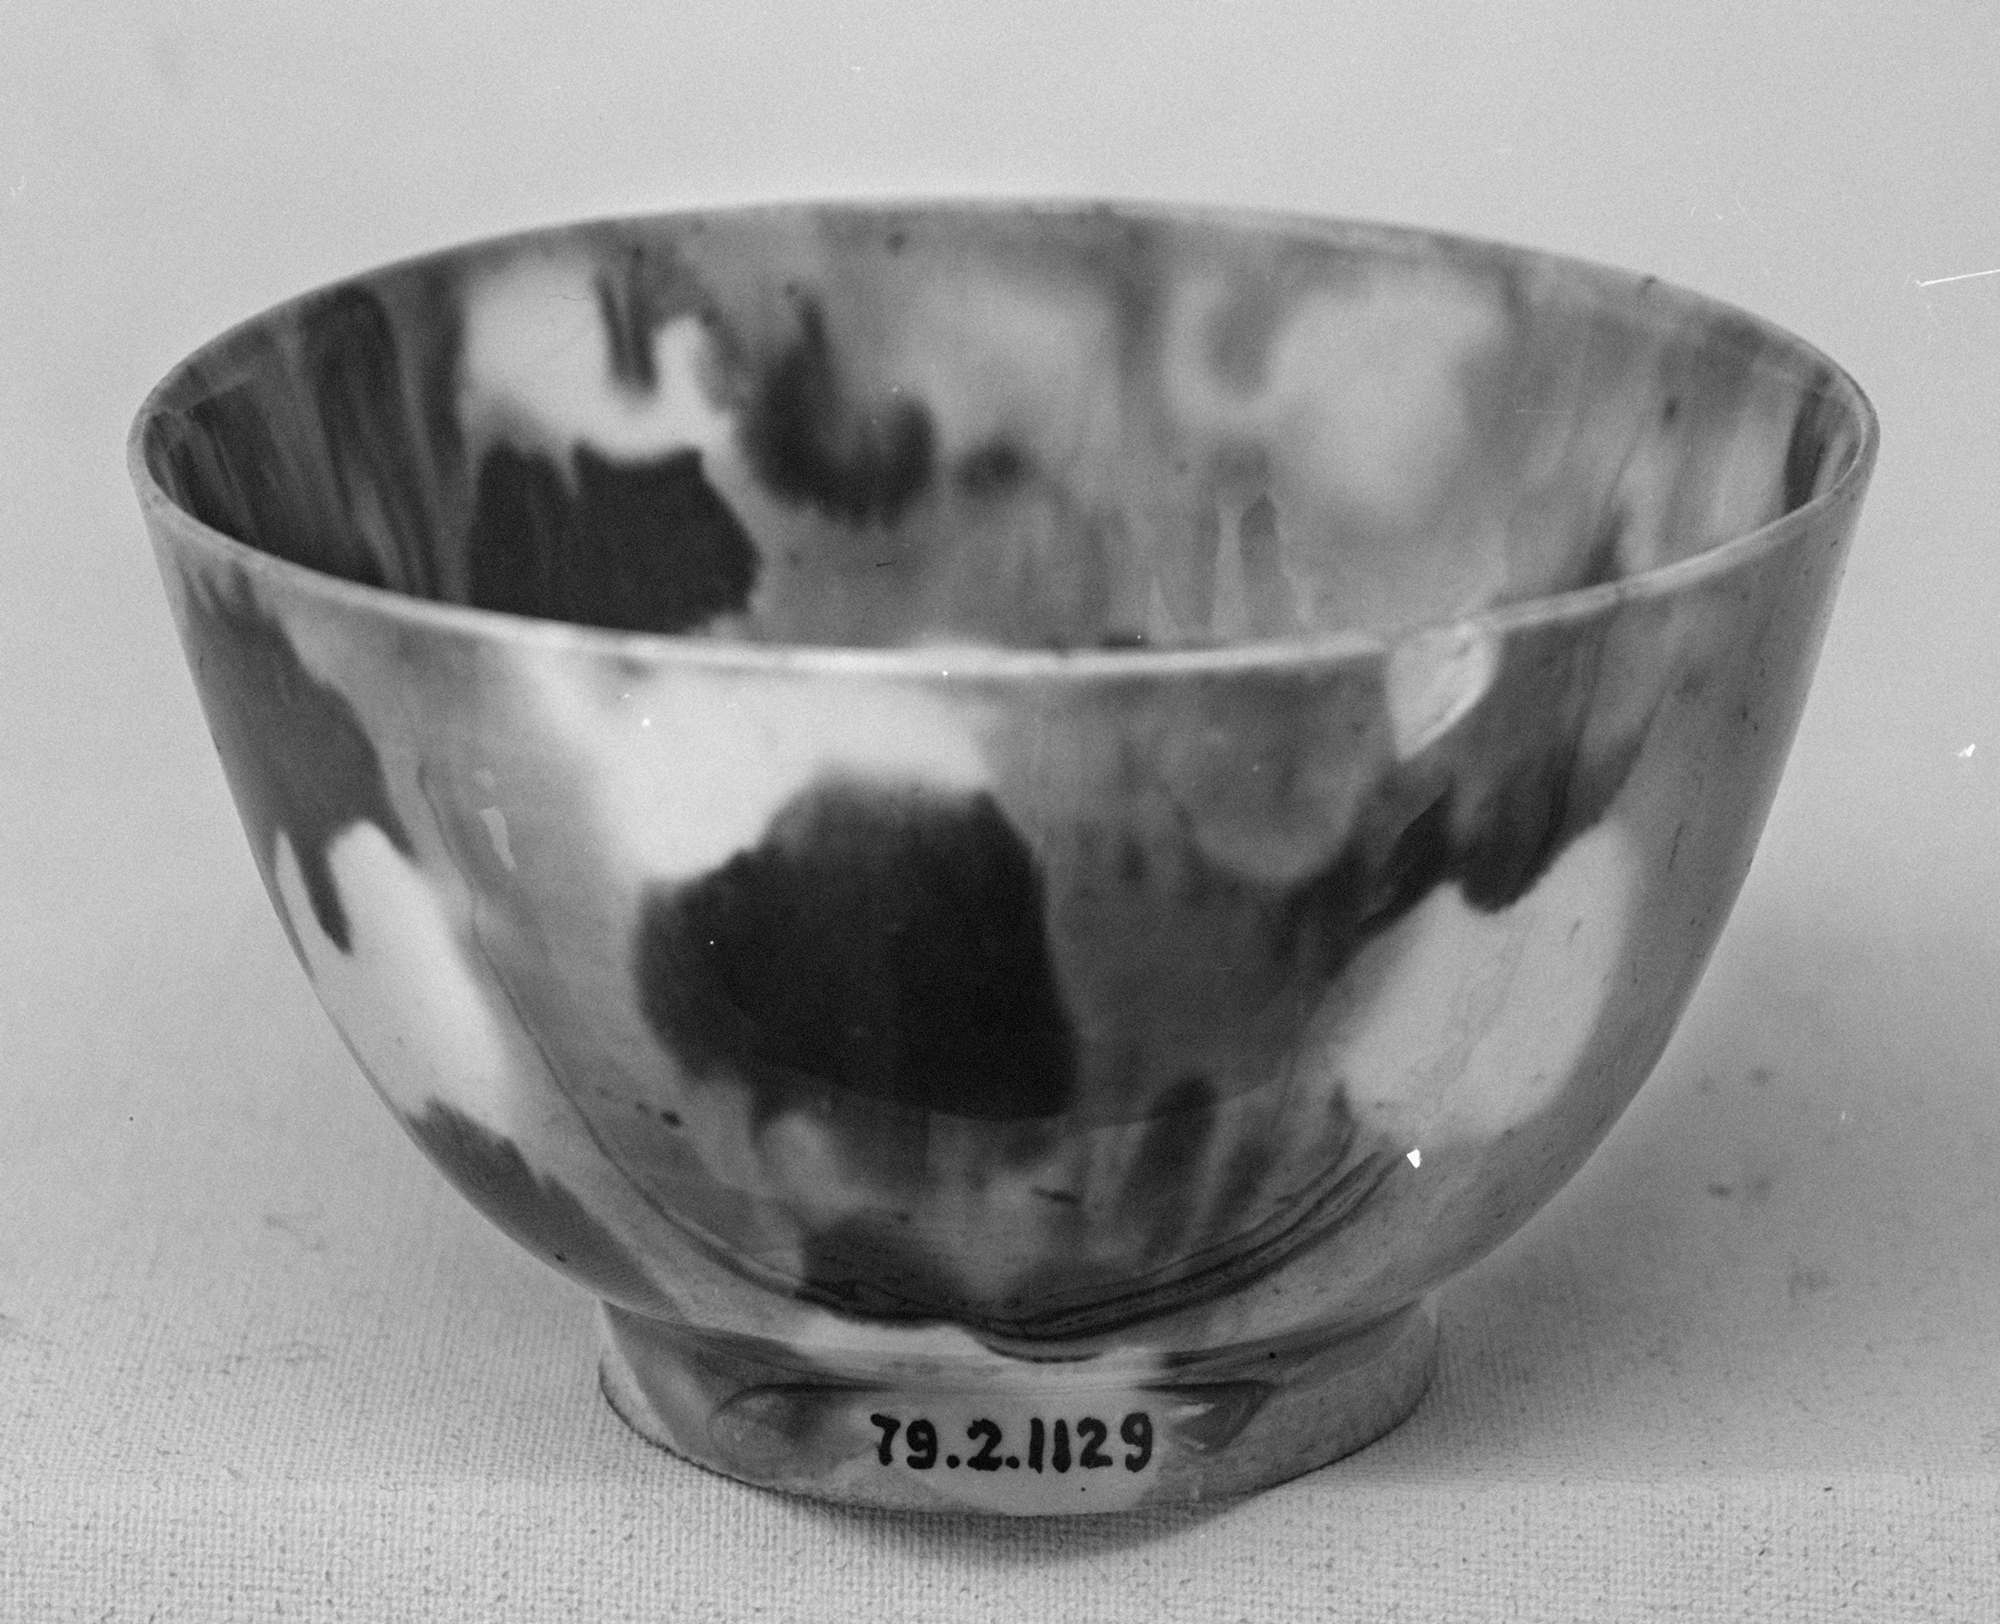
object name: cup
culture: chinese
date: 1701-1733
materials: biscuit, enamel, glaze, porcelain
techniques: painting, polychrome